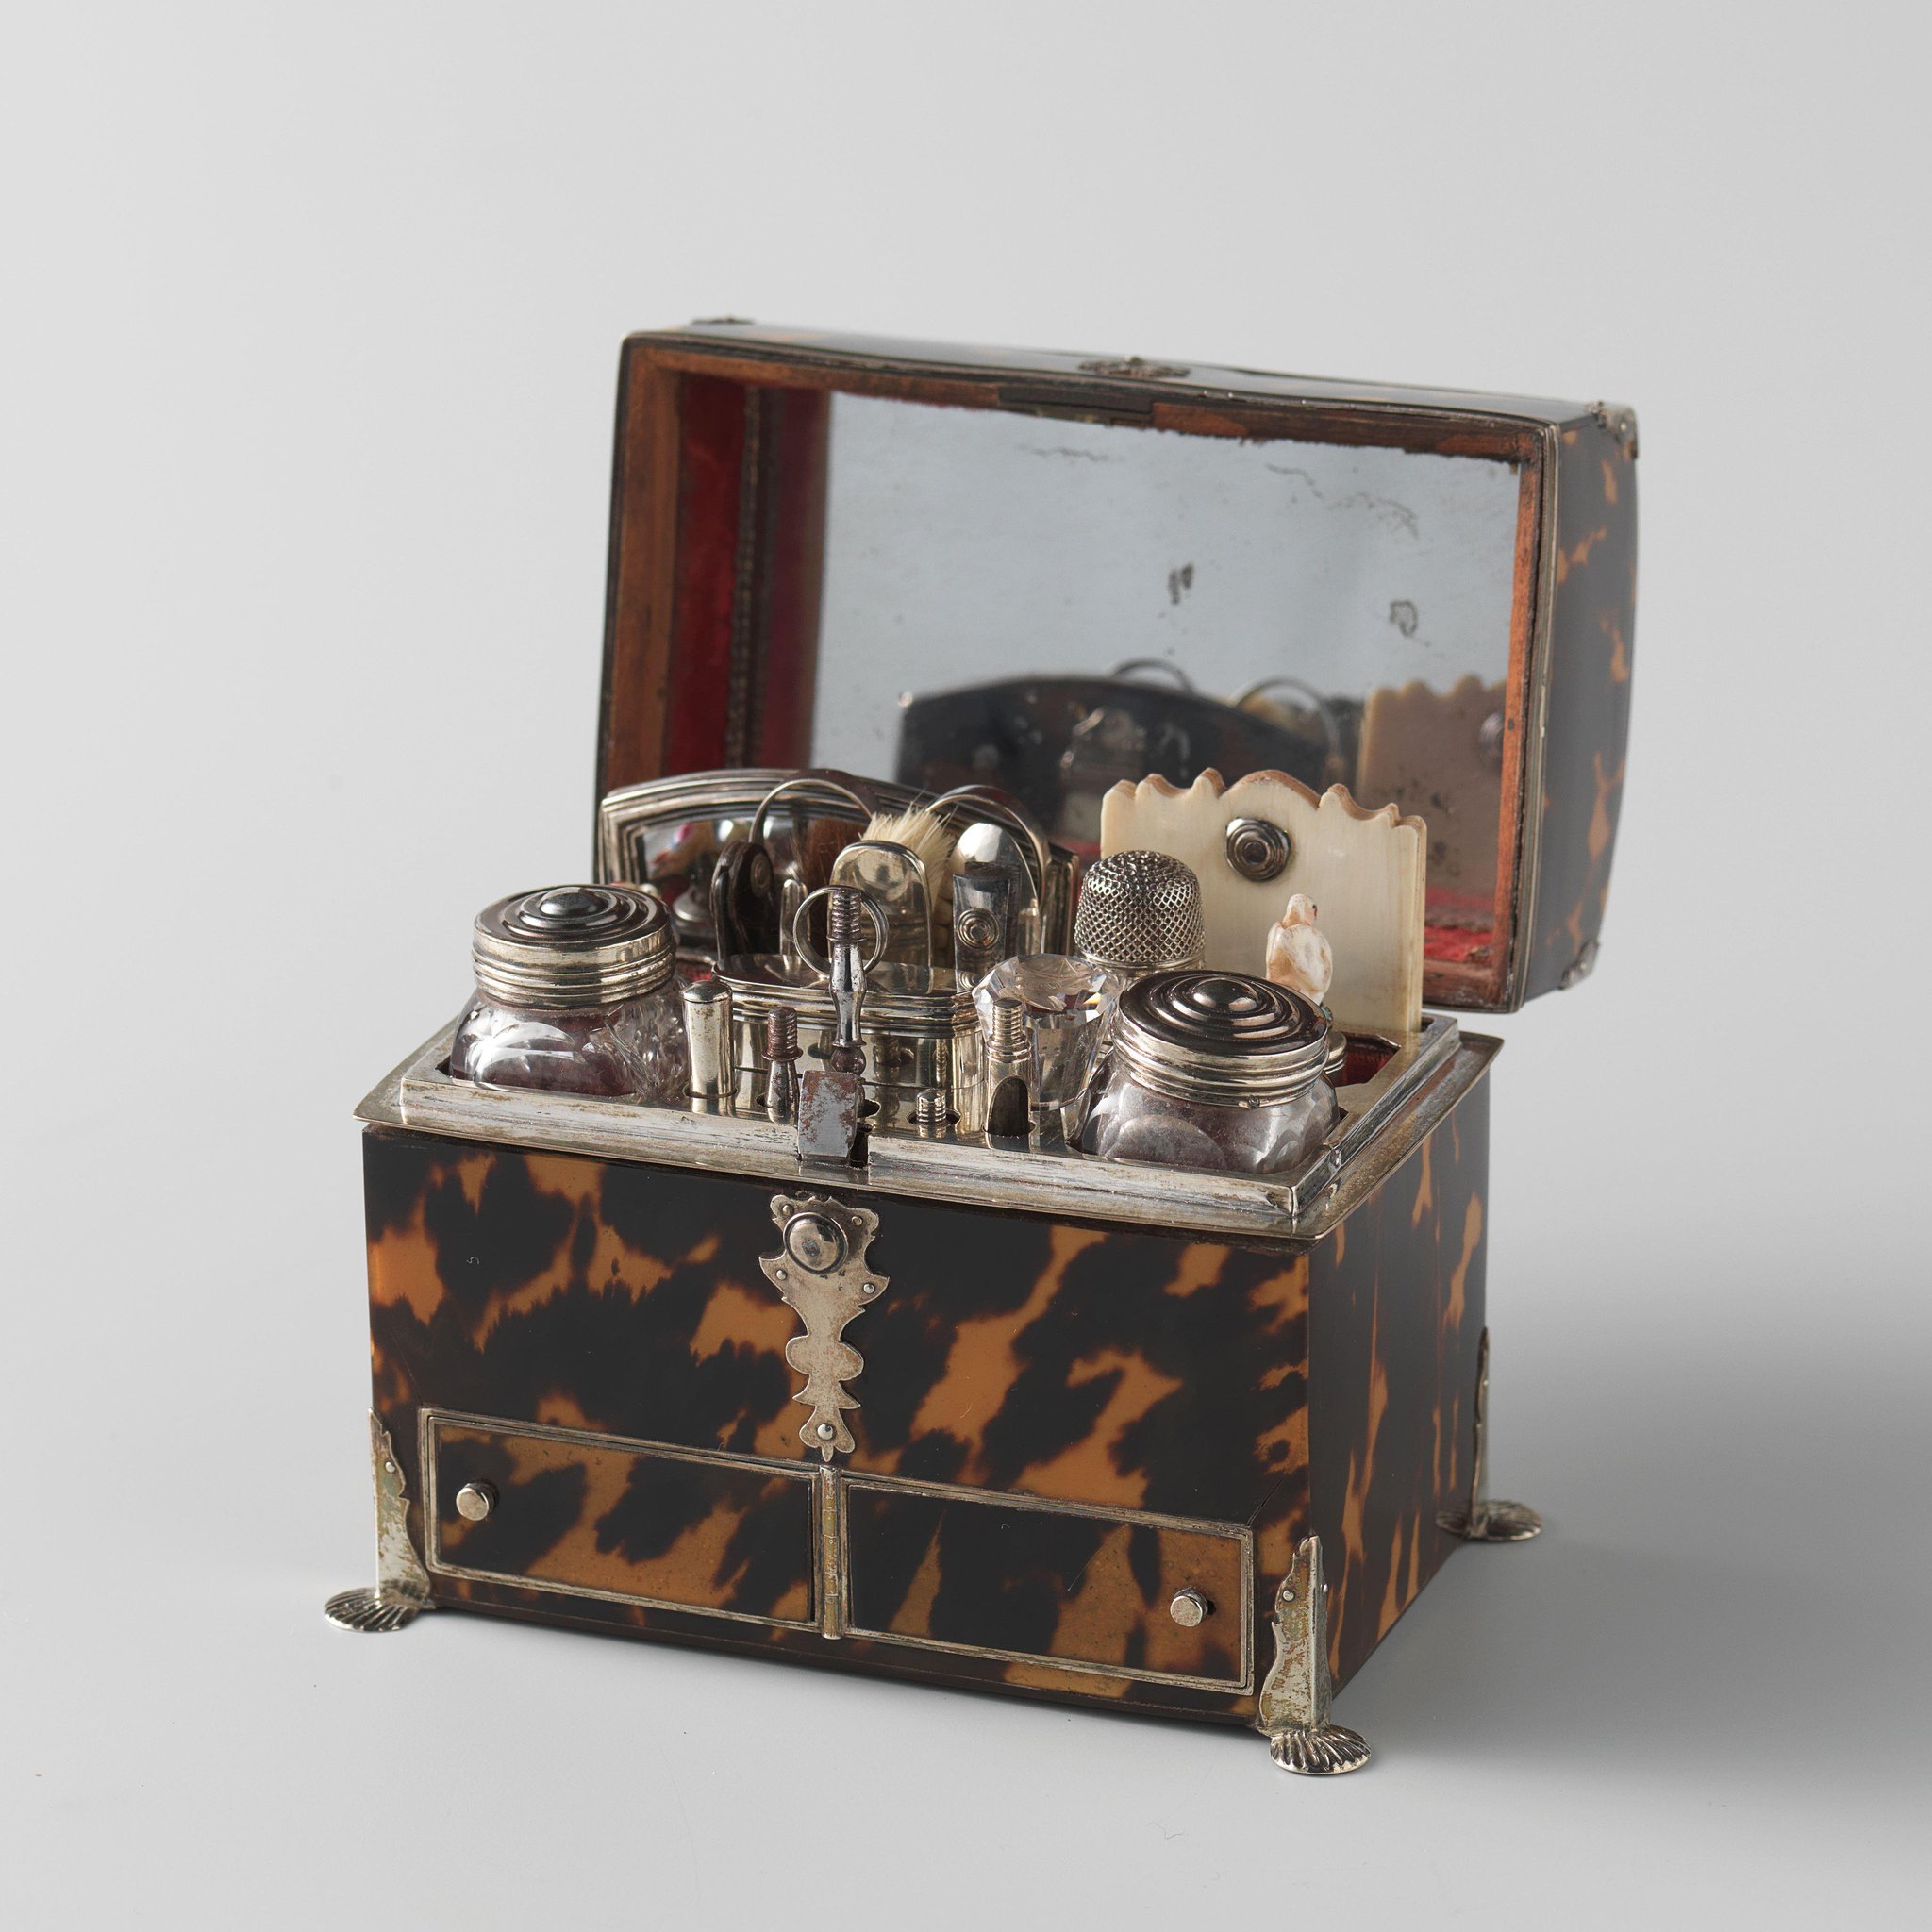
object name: reisnecessaire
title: Travel nécessaire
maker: Anonymous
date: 1675-1699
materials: crystal, glass, hair, ivory, silver, shell, velvet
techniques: manufacturing, colour, cutting, striking, weave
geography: netherlands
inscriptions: initials: ‘B en kroon’